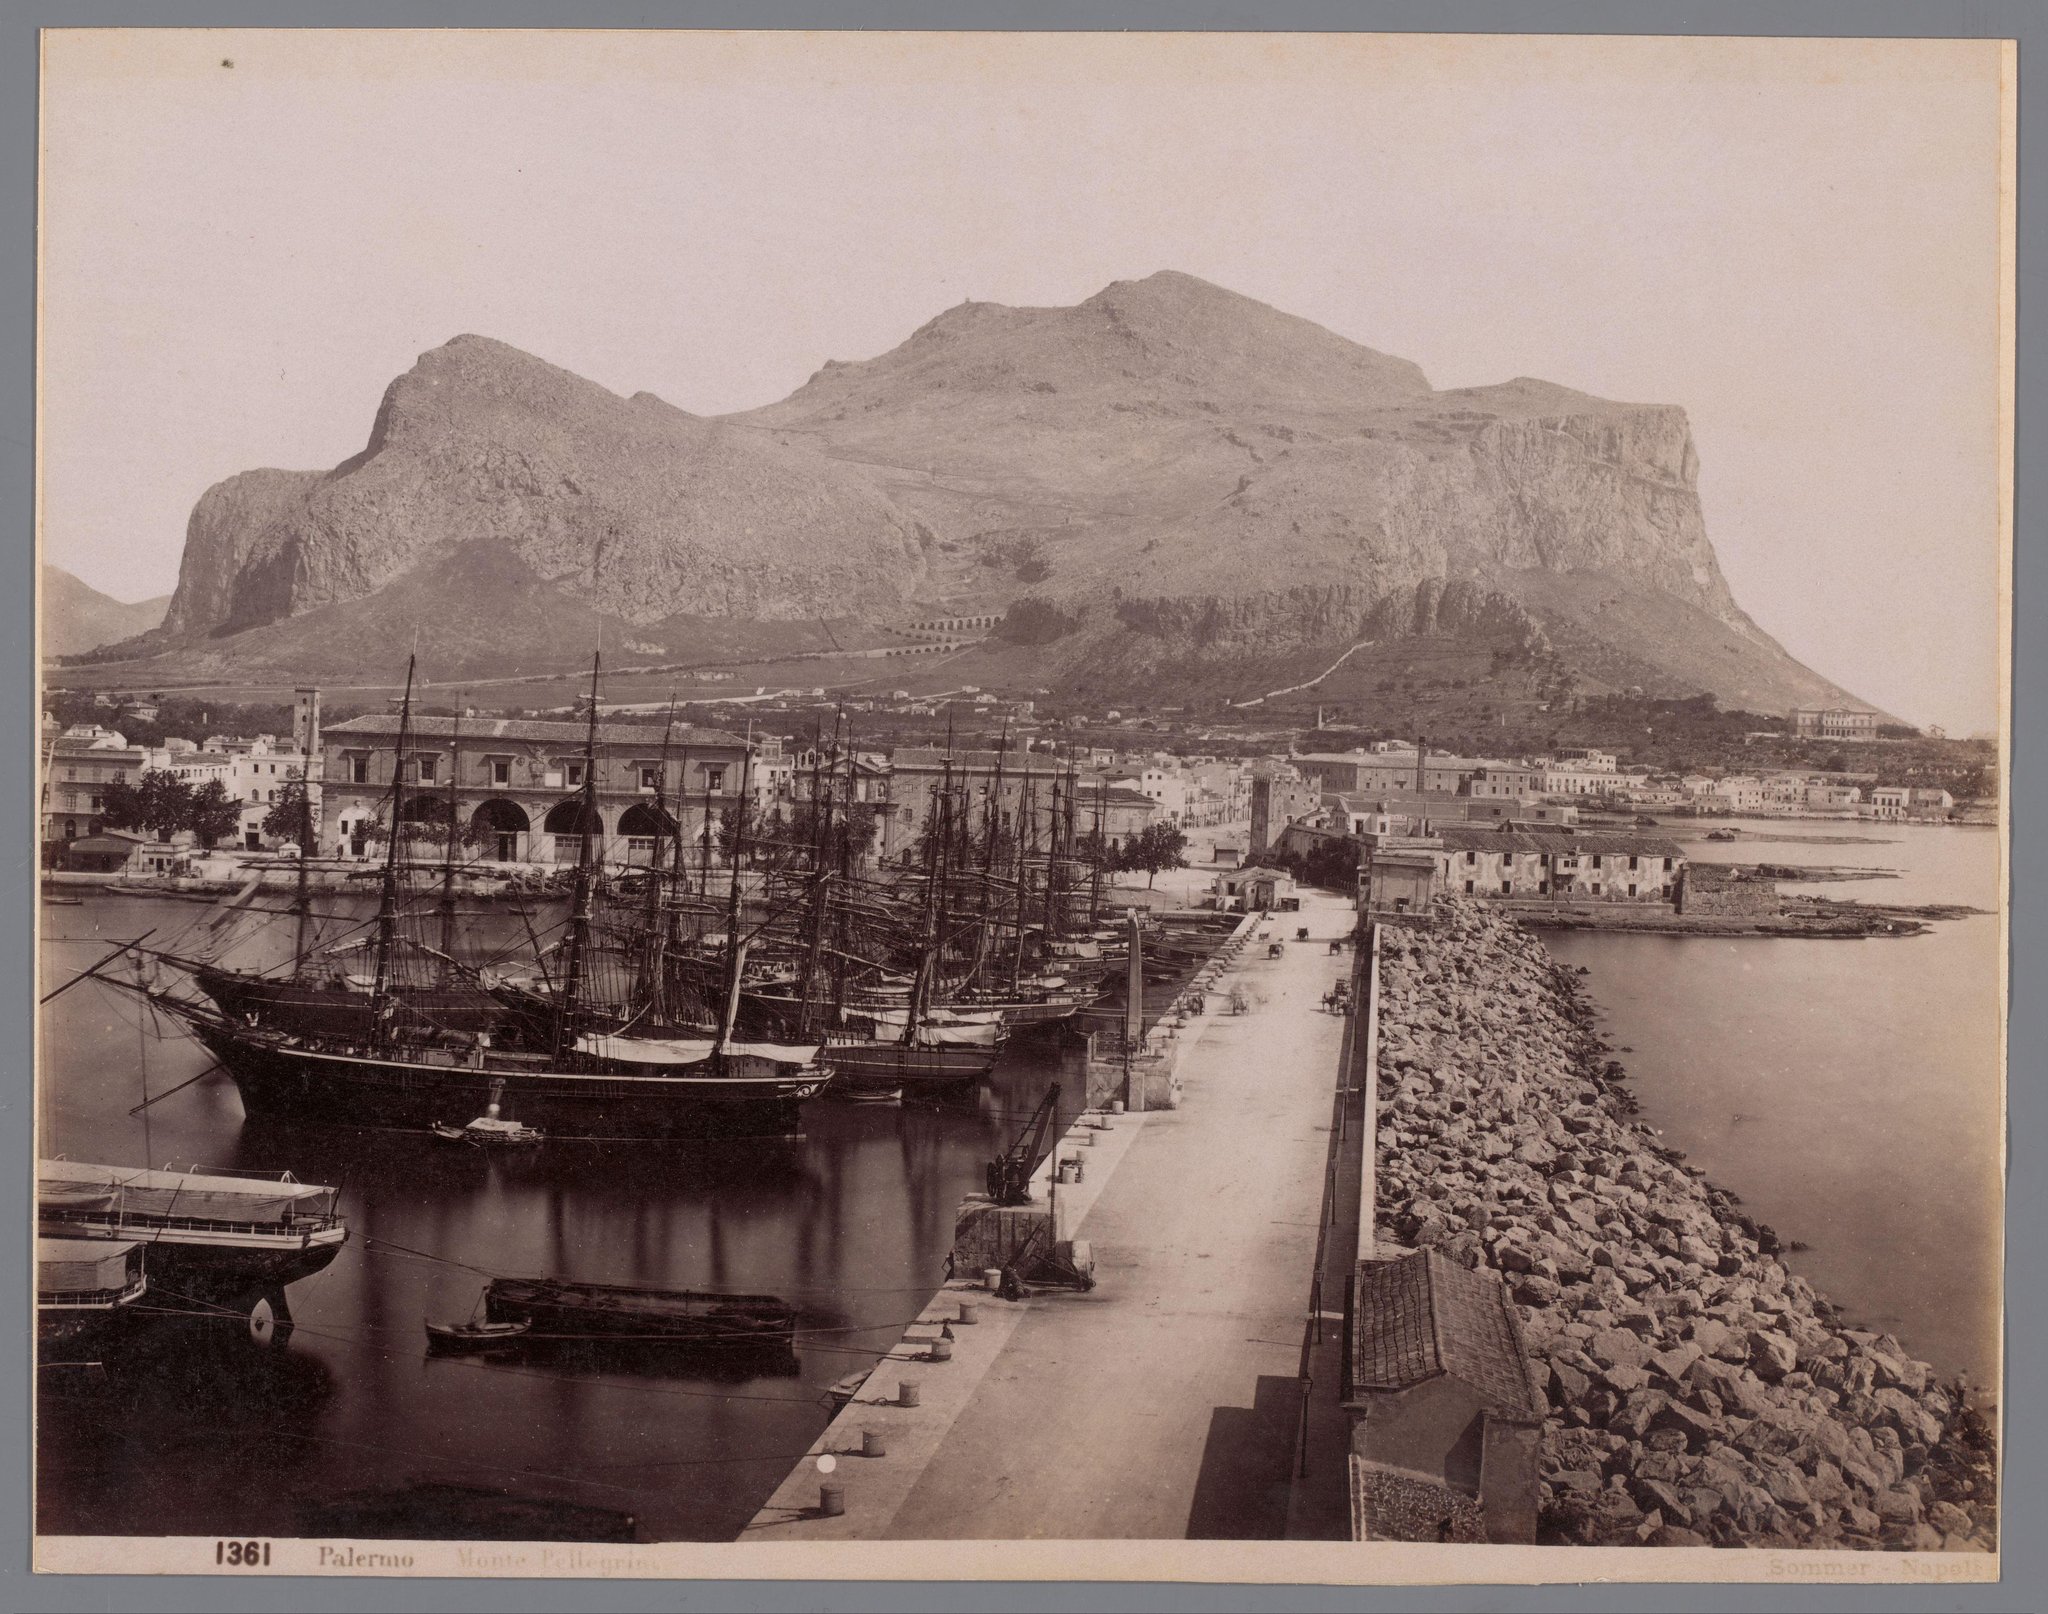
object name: photograph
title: Gezicht op Monte Pellegrino en de haven van Palermo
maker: giorgio sommer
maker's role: fotograaf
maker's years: 1834-1914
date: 1857-1914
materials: cardboard, paper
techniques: albumen print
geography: palermo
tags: harbour, mountains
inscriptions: number: ‘1361’